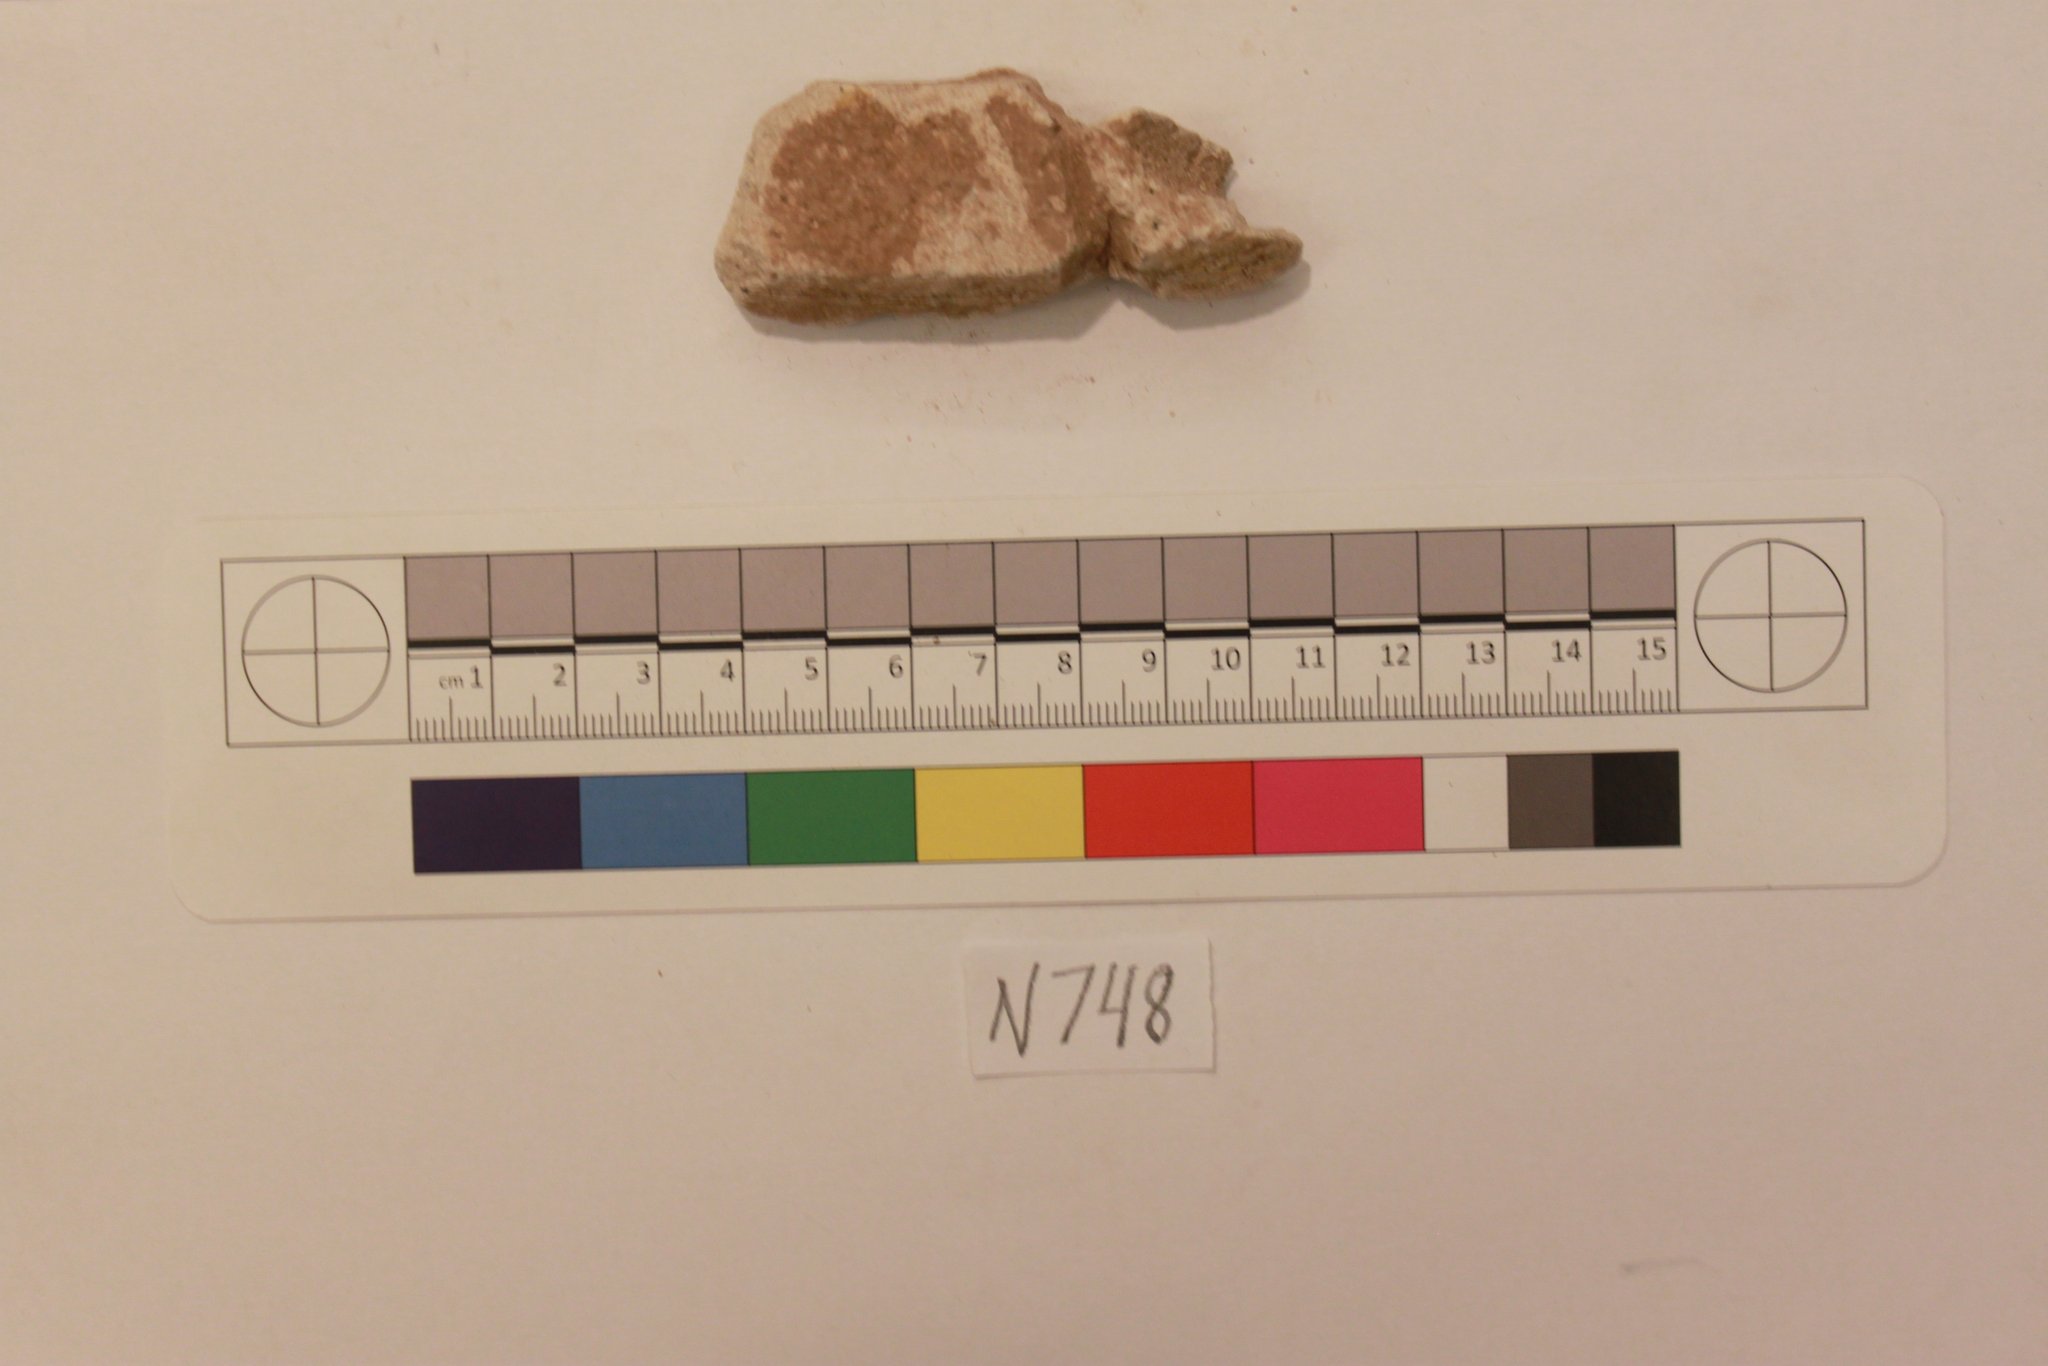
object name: fragment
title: Stucco Fragment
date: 701-1200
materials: plaster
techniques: carving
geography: iran